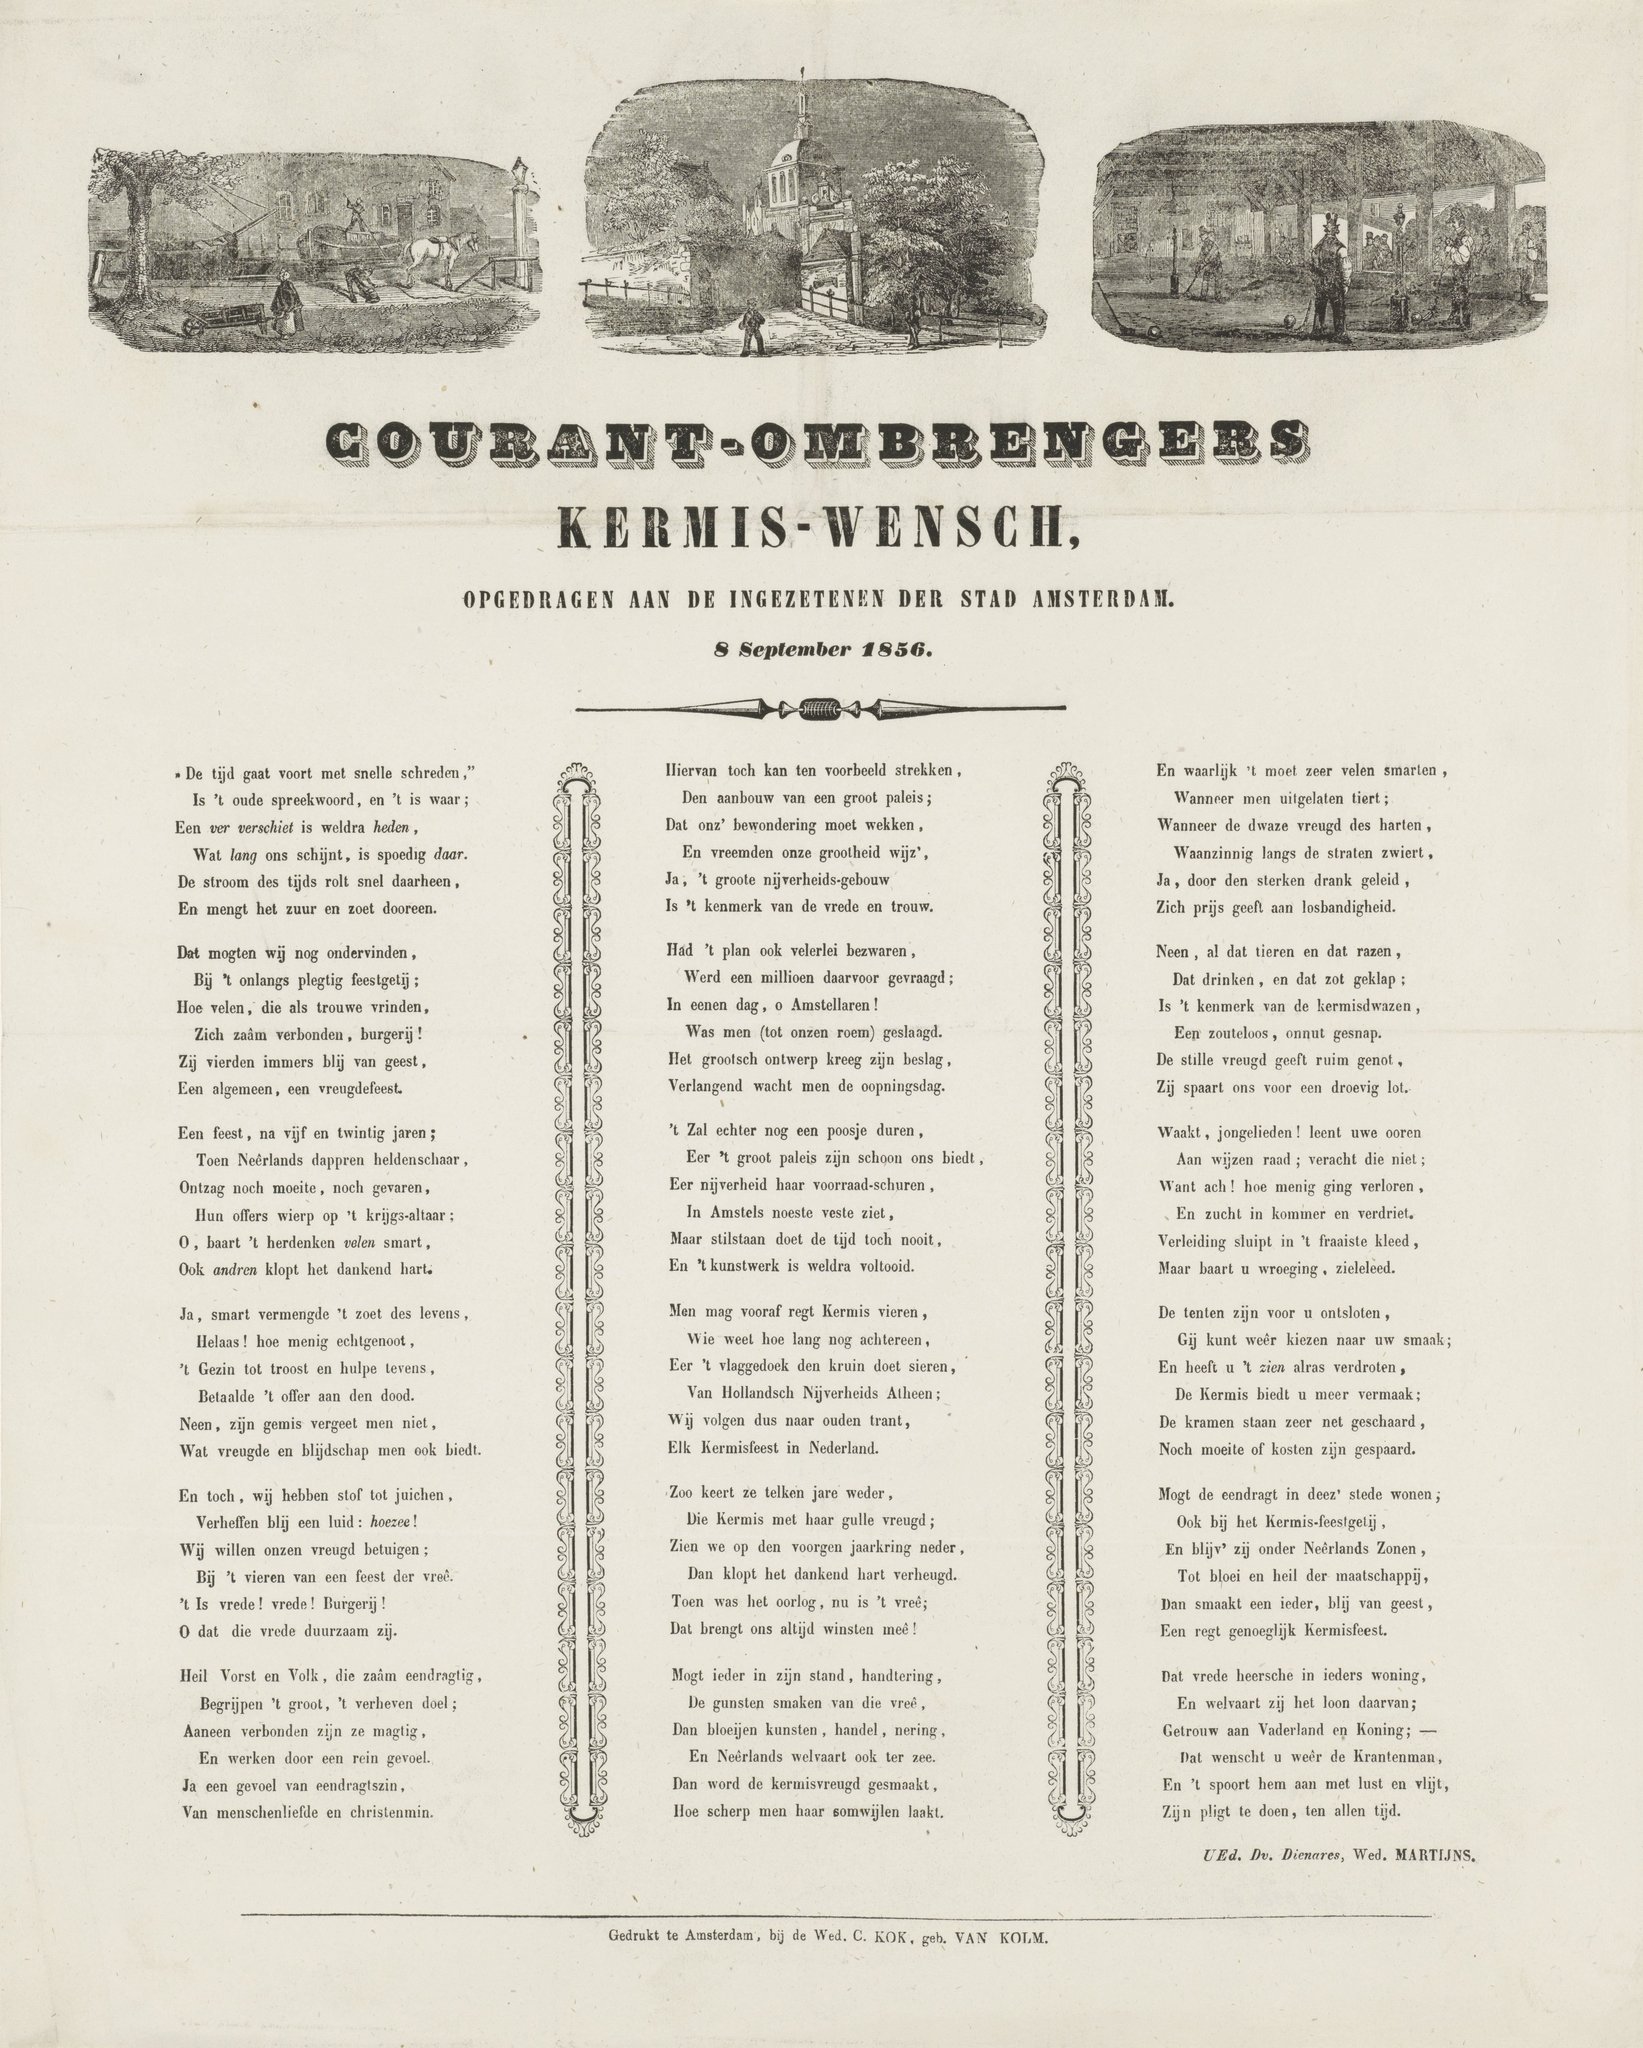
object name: print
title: Courant-Ombrengers Kermis-Wensch (...) 1856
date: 1856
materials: paper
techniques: letterpress printing, engraving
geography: amsterdam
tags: 'kolf' (ball game), amsterdam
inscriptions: collector's mark: Lugt 2228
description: Kermisprent namens de ombrengers van couranten (krantenbezorgers) te Amsterdam, 8 september 1856. Bovenaan drie vignetten met afbeeldingen ontleend aan boeken, centraal de Muiderpoort (?), links bedrijvigheid langs een gracht, rechts heren op een kolfbaan. Onderaan een gedicht in drie kolommen. Van de courantombrengster: wed. Martijns.